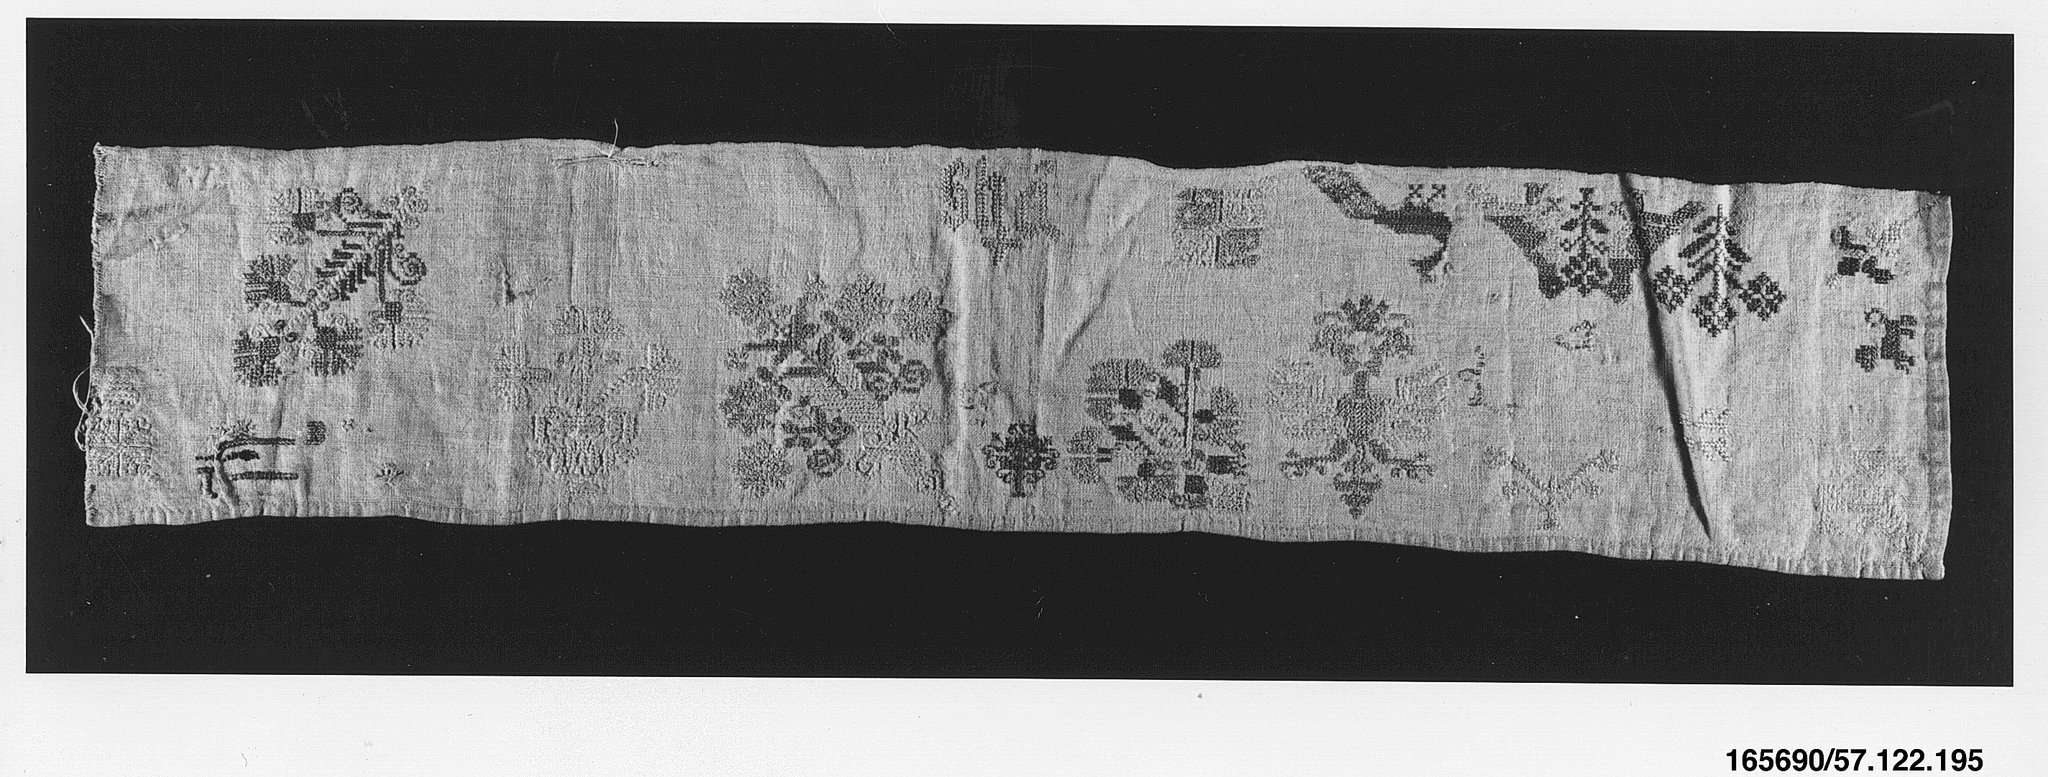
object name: sampler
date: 1701-1800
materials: linen, silk